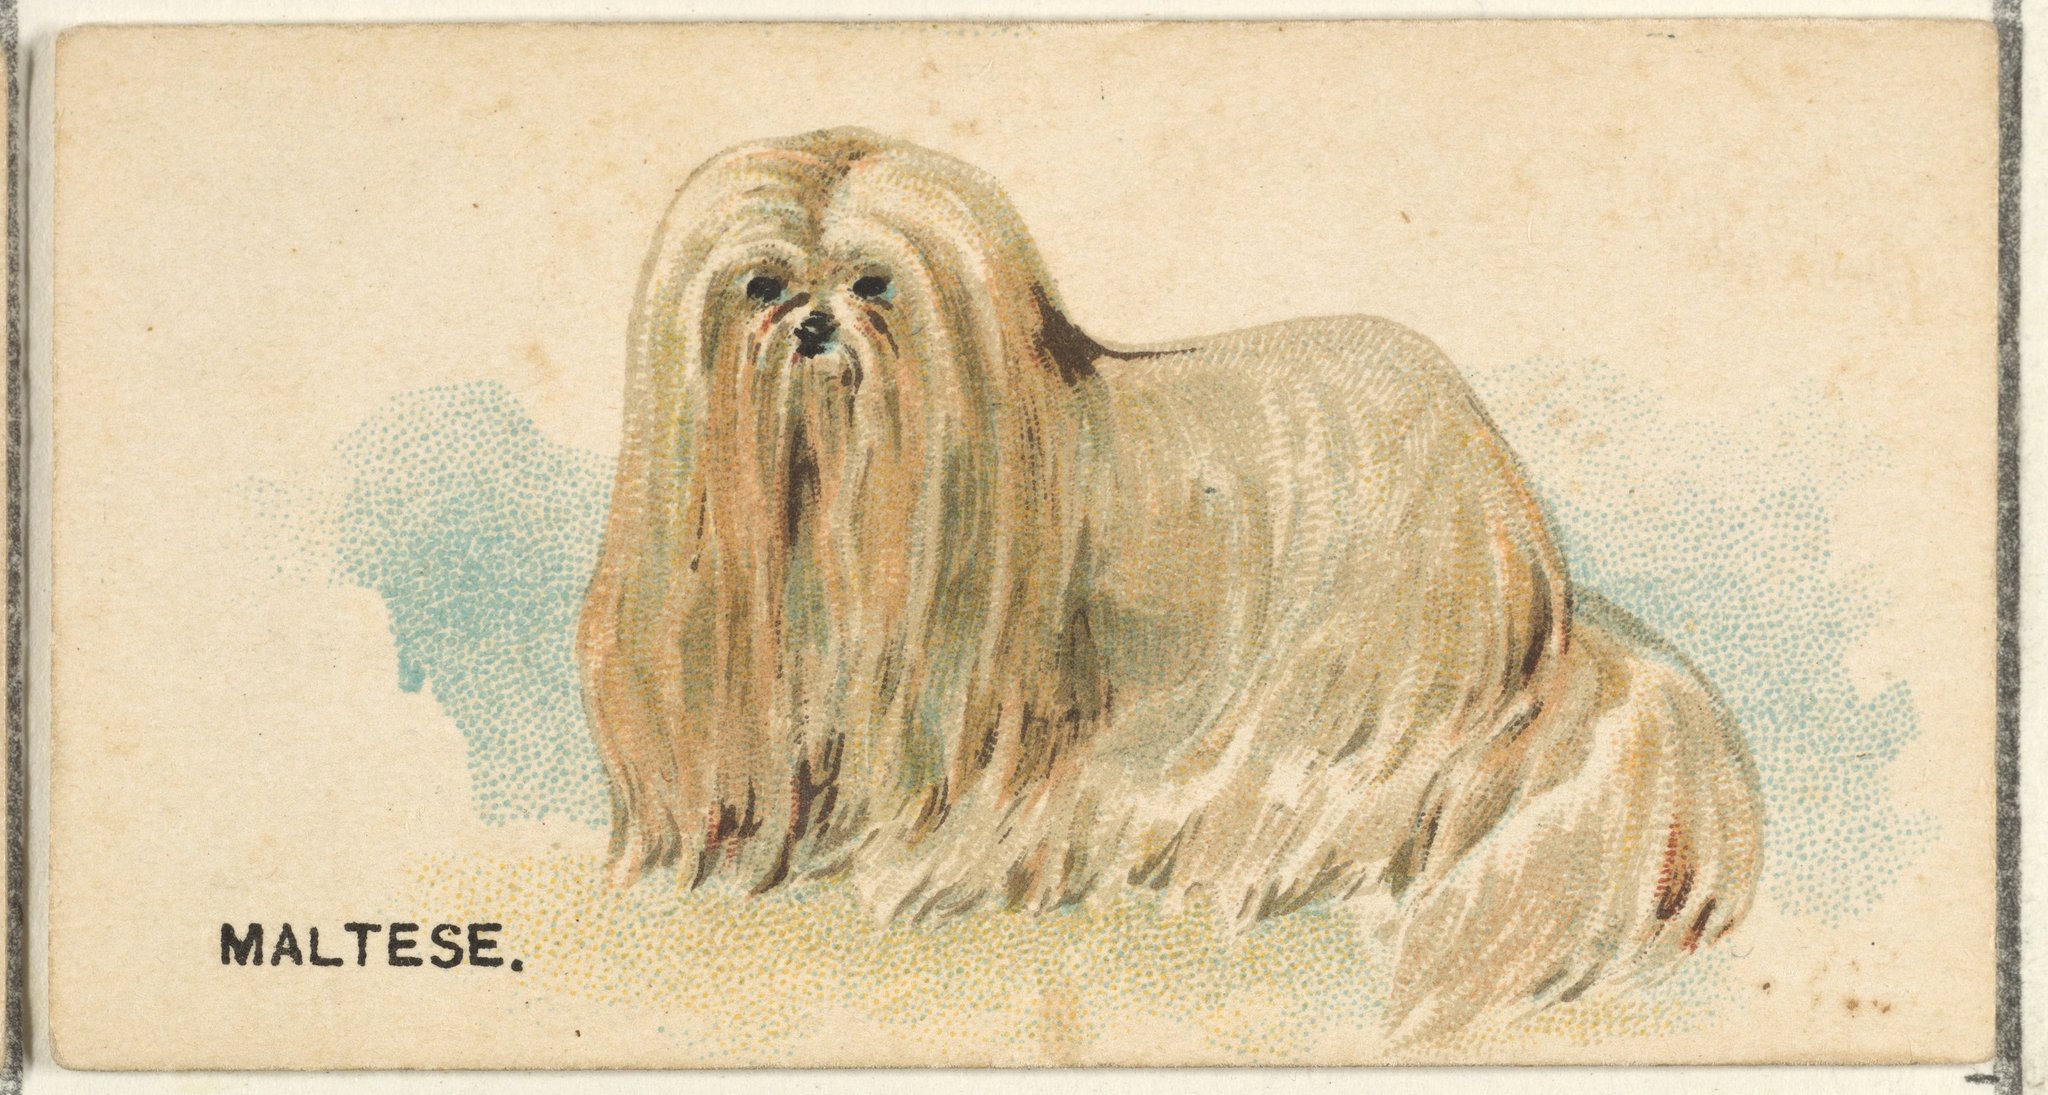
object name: print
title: Maltese, from the Dogs of the World series for Old Judge Cigarettes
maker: goodwin & company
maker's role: publisher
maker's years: 1850-1950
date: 1890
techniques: color lithograph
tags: dogs